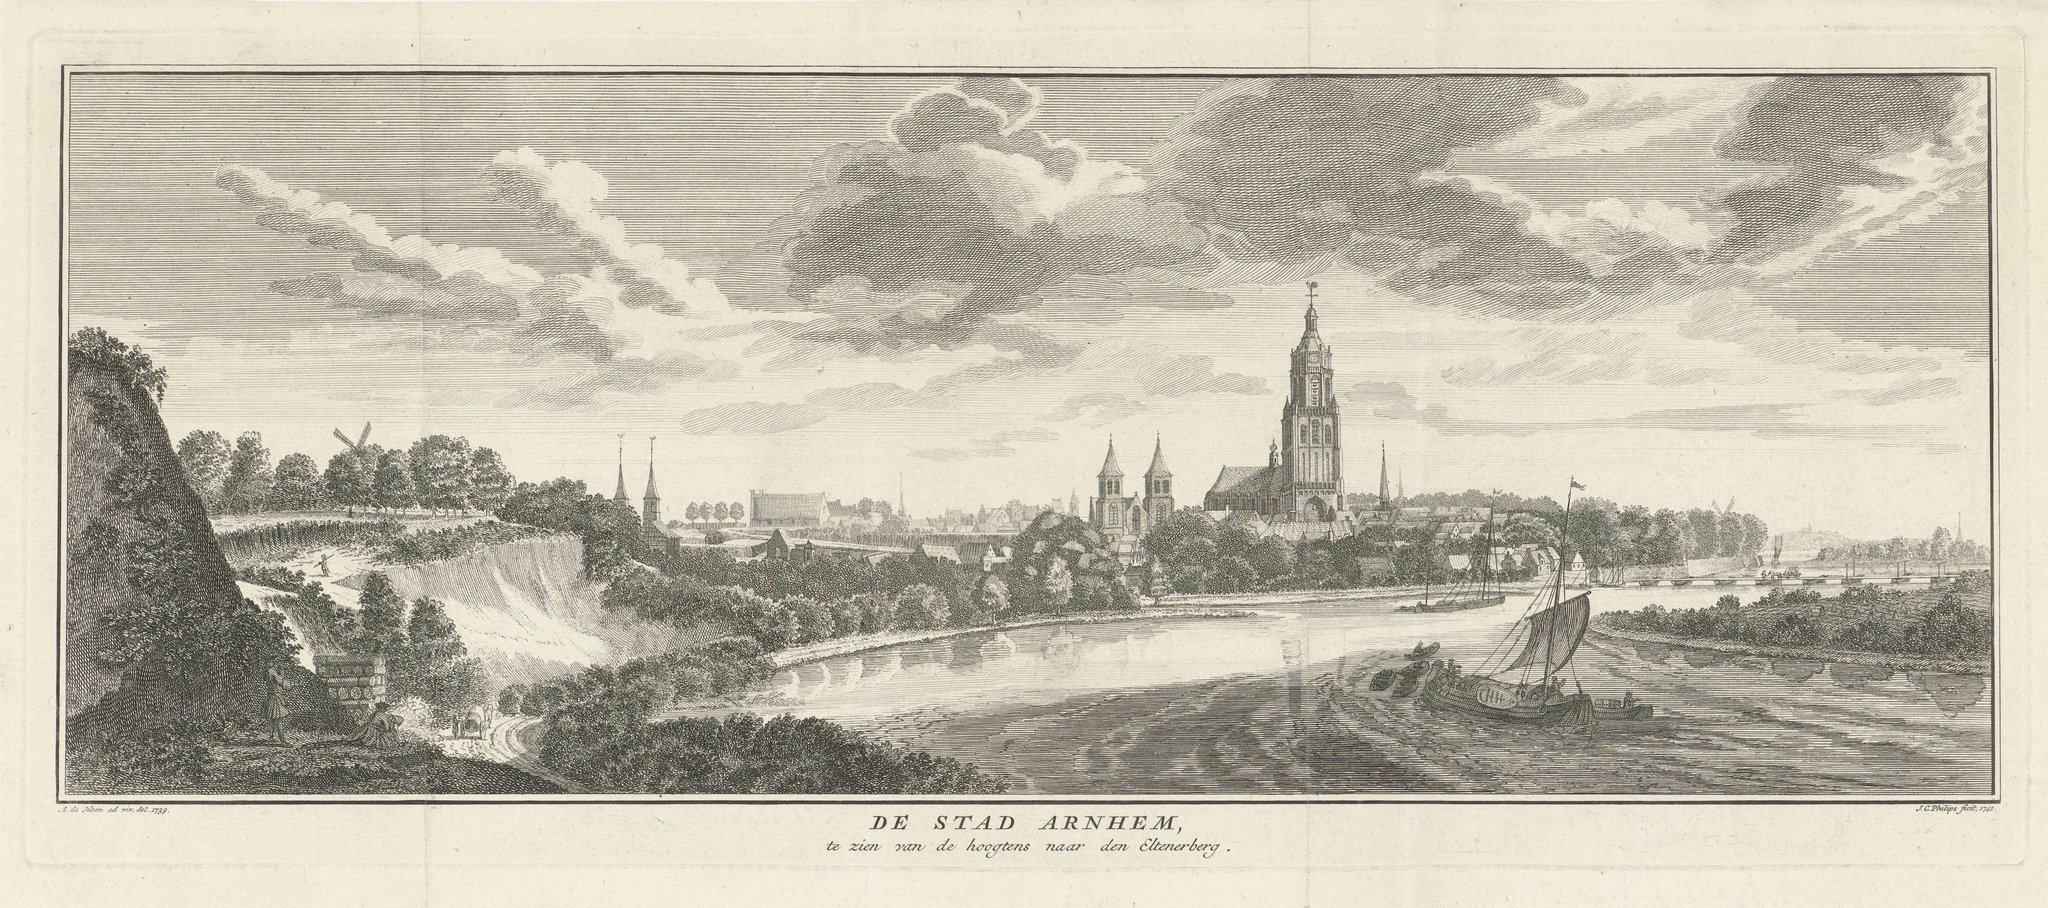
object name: print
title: Gezicht op Arnhem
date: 1741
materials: paper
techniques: engraving, etching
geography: amsterdam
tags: city-view in general; 'veduta', arnhem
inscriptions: collector's mark: Lugt 2228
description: Prent ook gebruikt in: Wagenaar, Jan. Tegenwoordige staat der Vereenigde Nederlanden, derde deel. Vervattende de beschryving der provincie Gelderland (…) / Hedendaagsche historie, of tegenwoordige staat van alle volkeren; XIIIde deel (…). Amsterdam: Isaak Tirion, 1741.